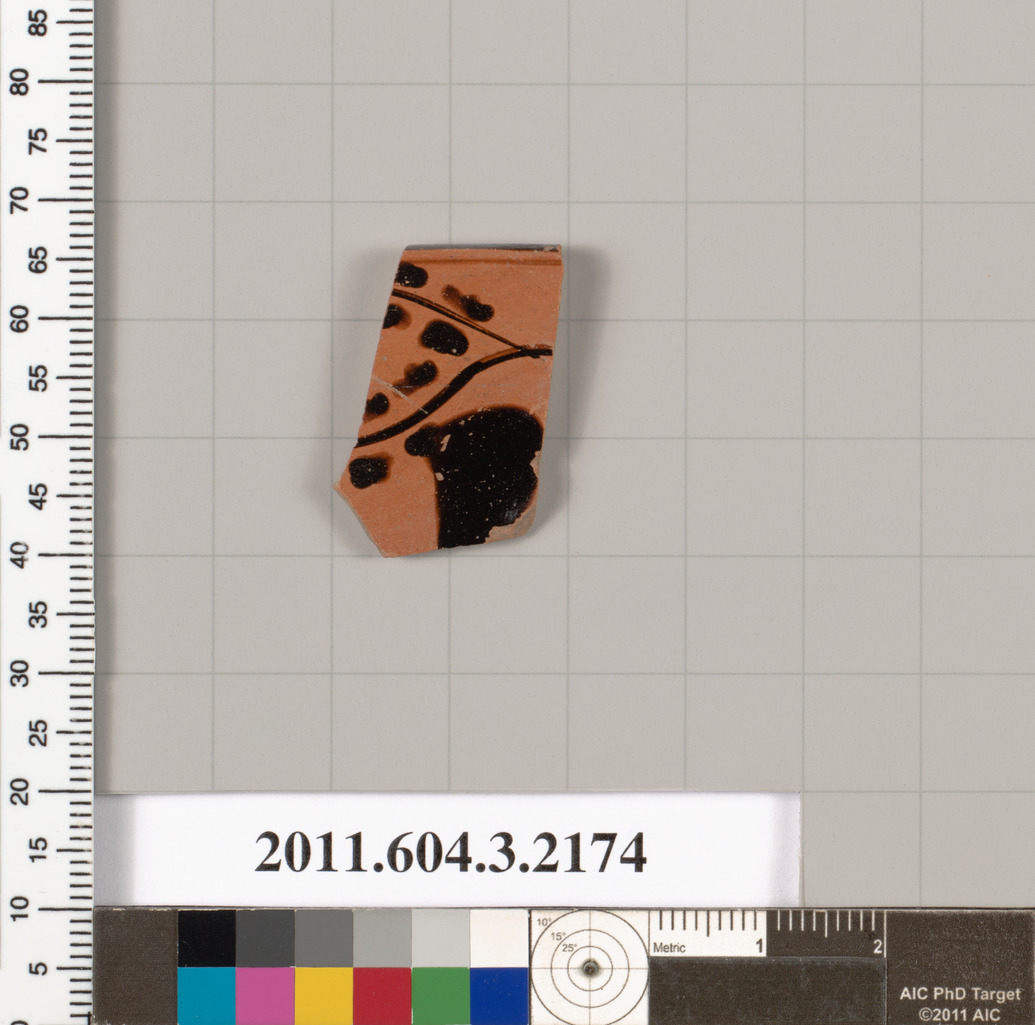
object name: kylix fragment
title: Terracotta rim fragment of a kylix (drinking cup)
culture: greek, attic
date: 525-501 BCE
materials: terracotta